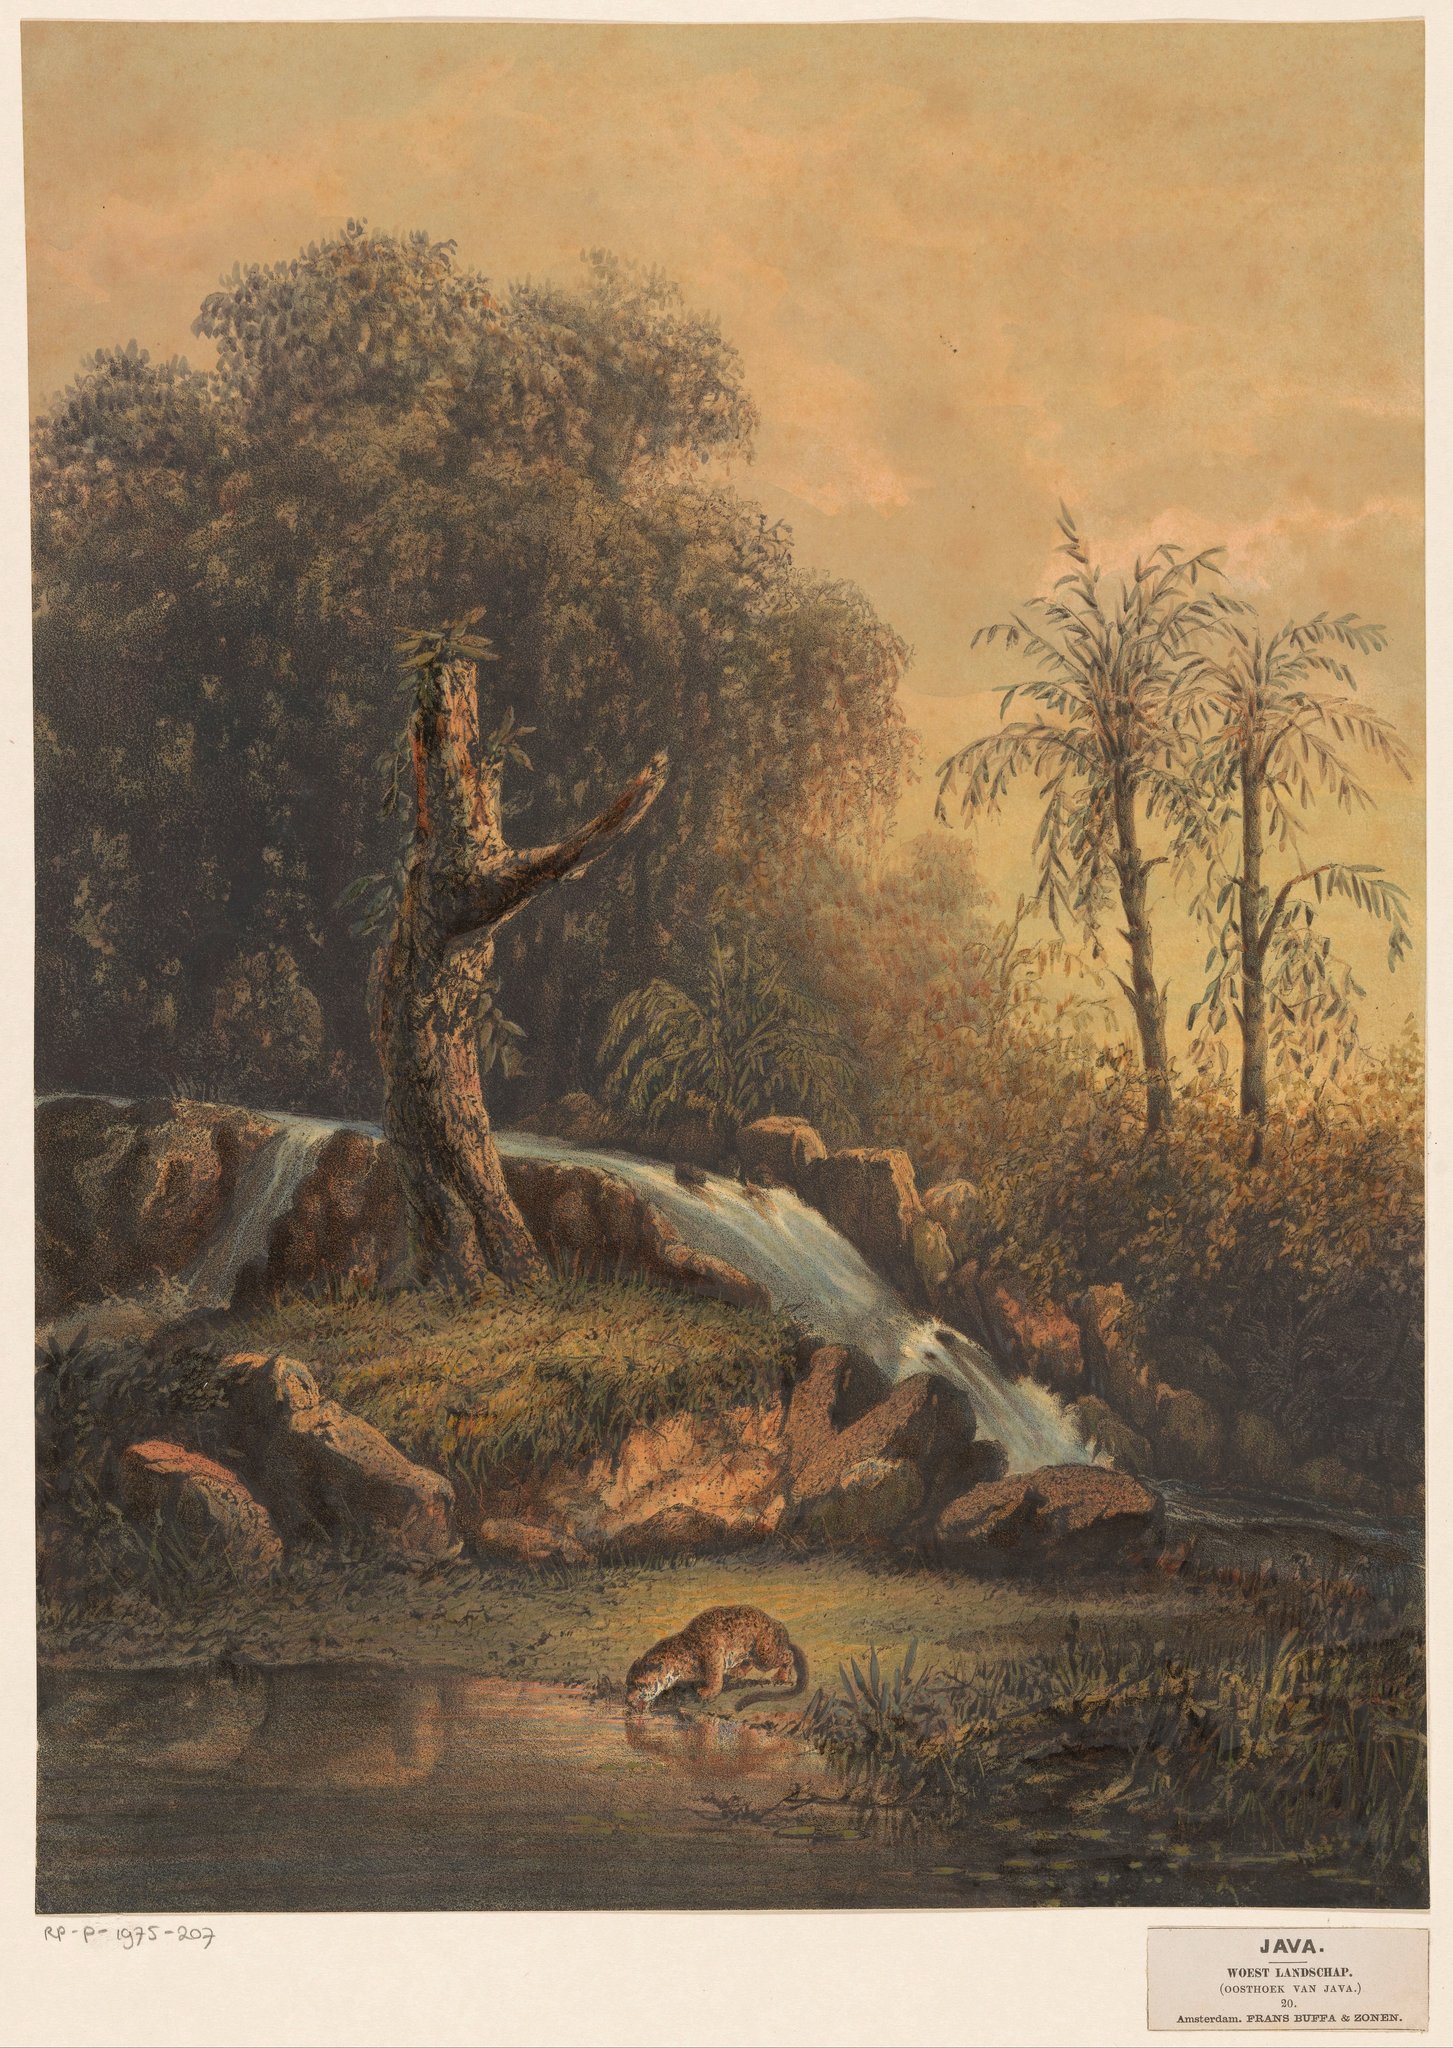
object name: print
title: Woest landschap (oosthoek van Java)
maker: johan conrad greive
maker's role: draughtsman, painter, print maker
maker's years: 1837-1891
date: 1869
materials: paper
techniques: lithograph, hand coloring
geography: dutch east indies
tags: beasts of prey, predatory animals: leopard, landscapes in tropical and sub-tropical regions, waterfall (+ landscape with figures, staffage), java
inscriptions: collector's mark: Lugt 2228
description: De prent maakt deel uit van een omslag met een tekstblad en 24 losse prenten.